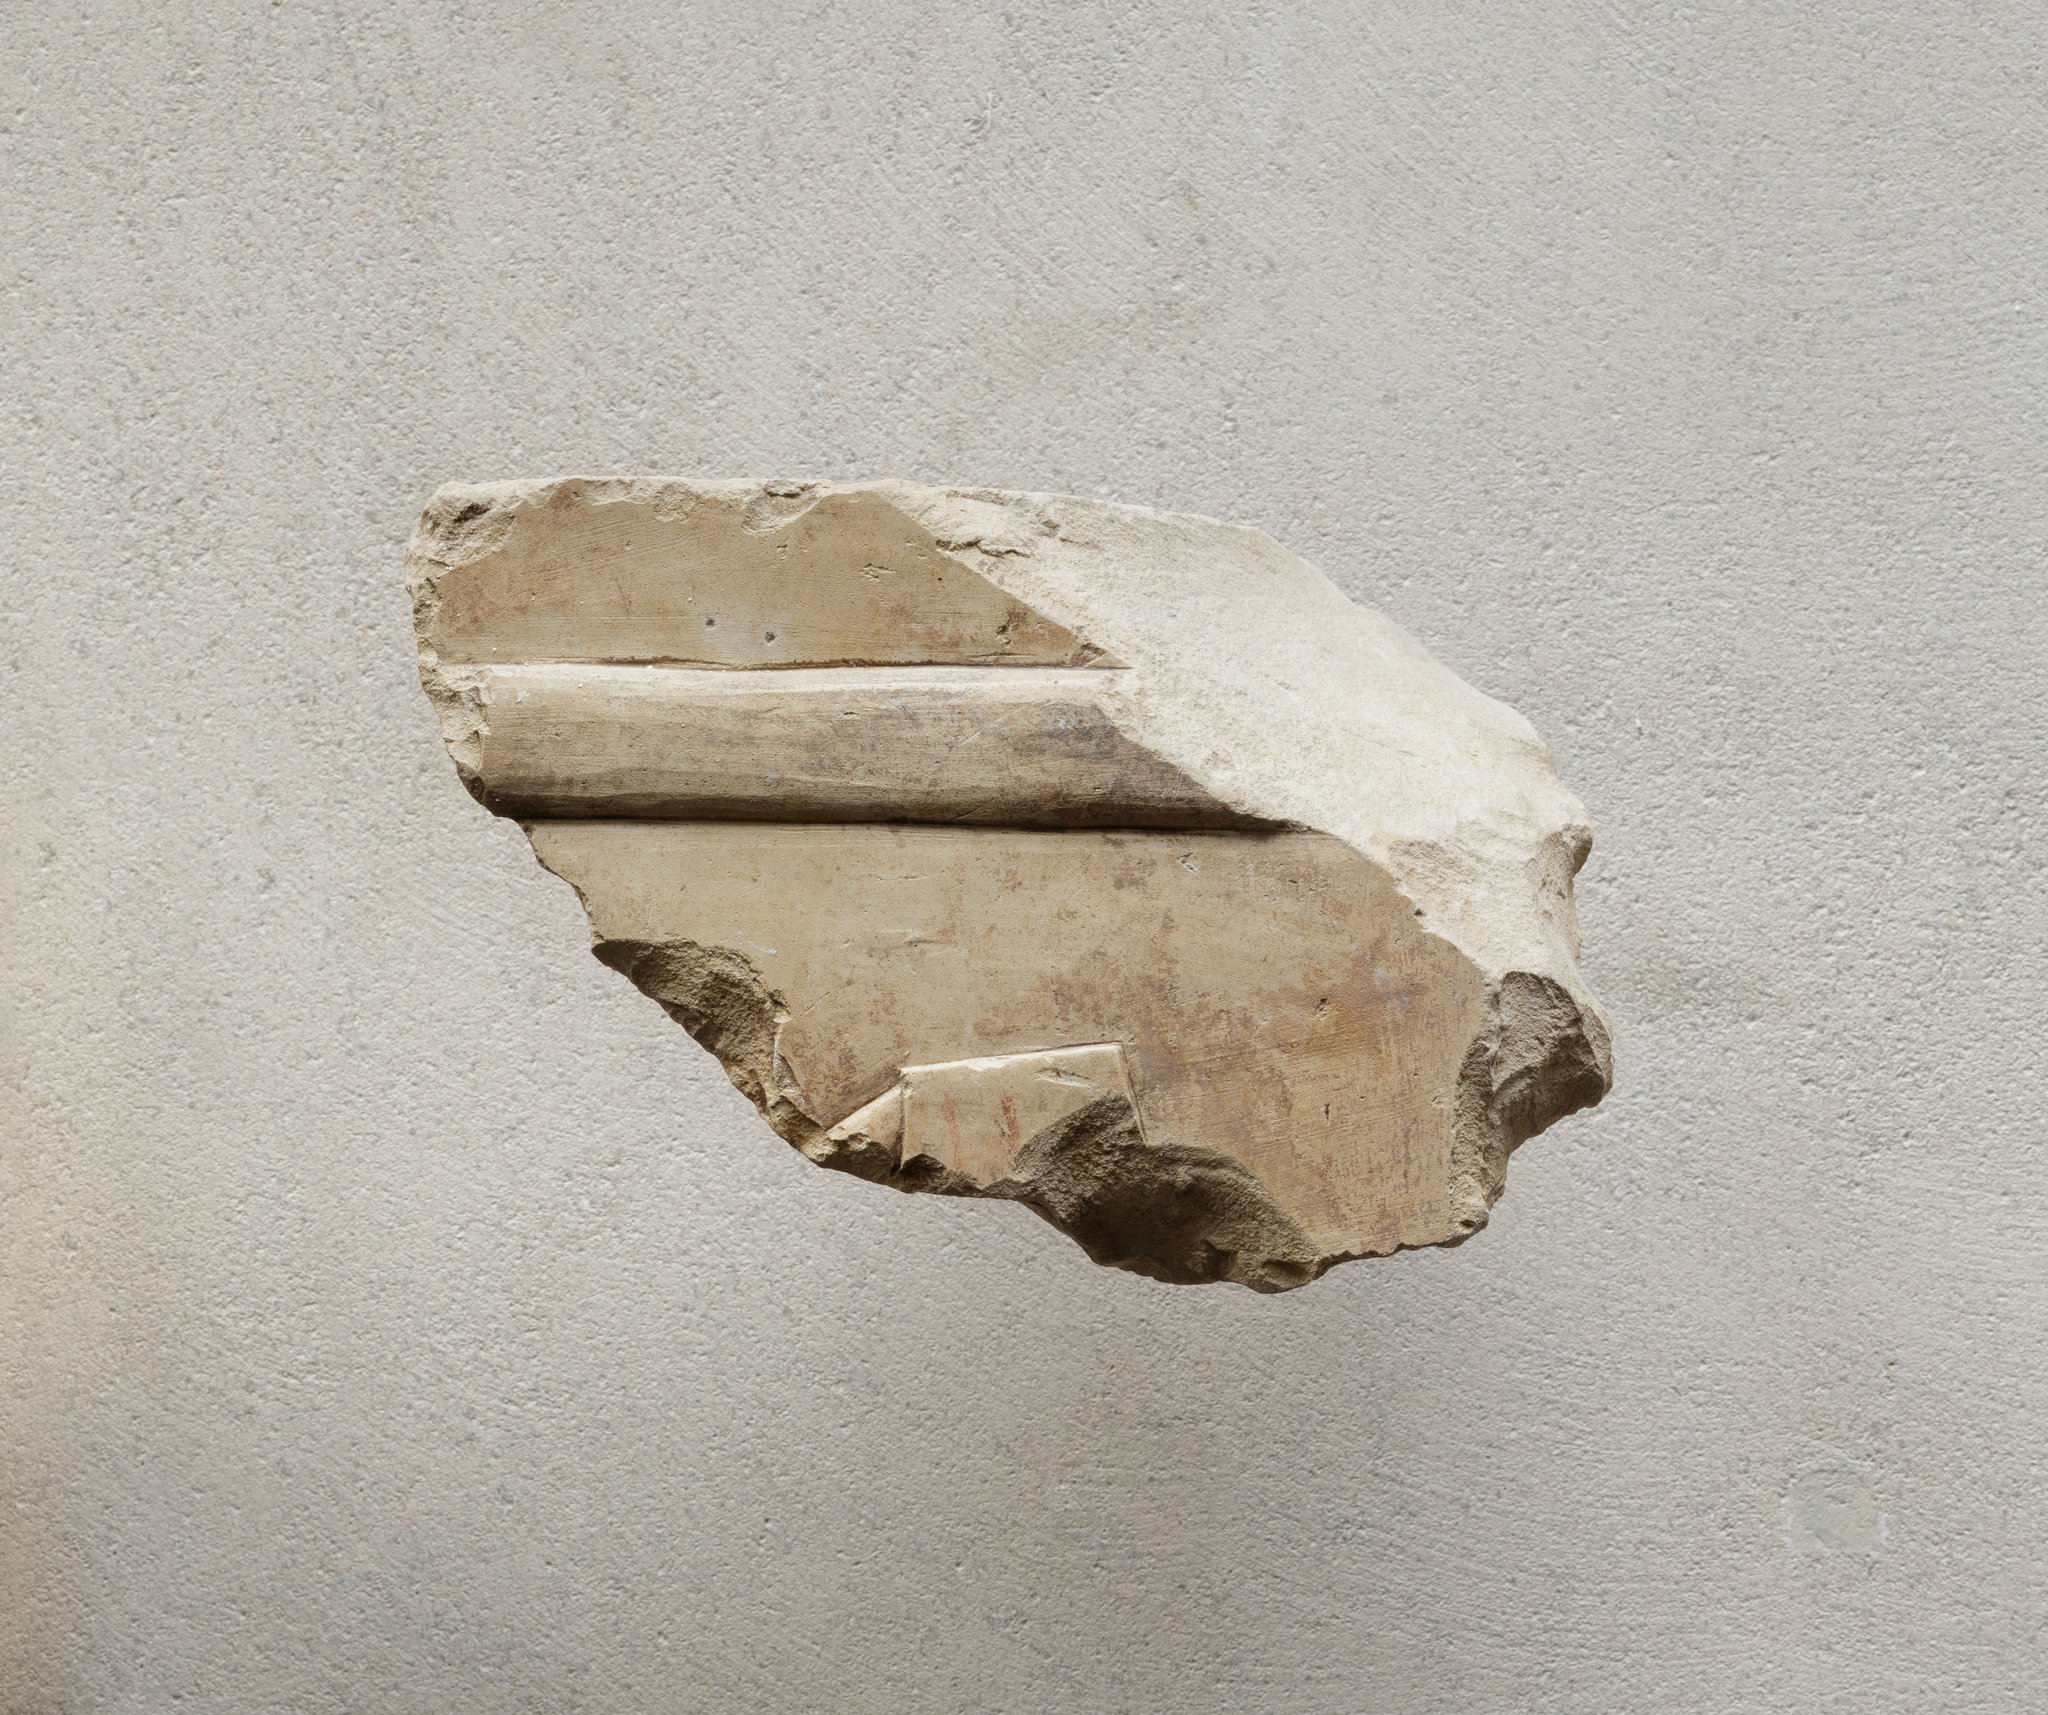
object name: relief, tip of a sunshade, neferu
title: Relief showing the tip of a sunshade - see 26.3.353-3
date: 2051-2030 BCE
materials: limestone, paint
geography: egypt